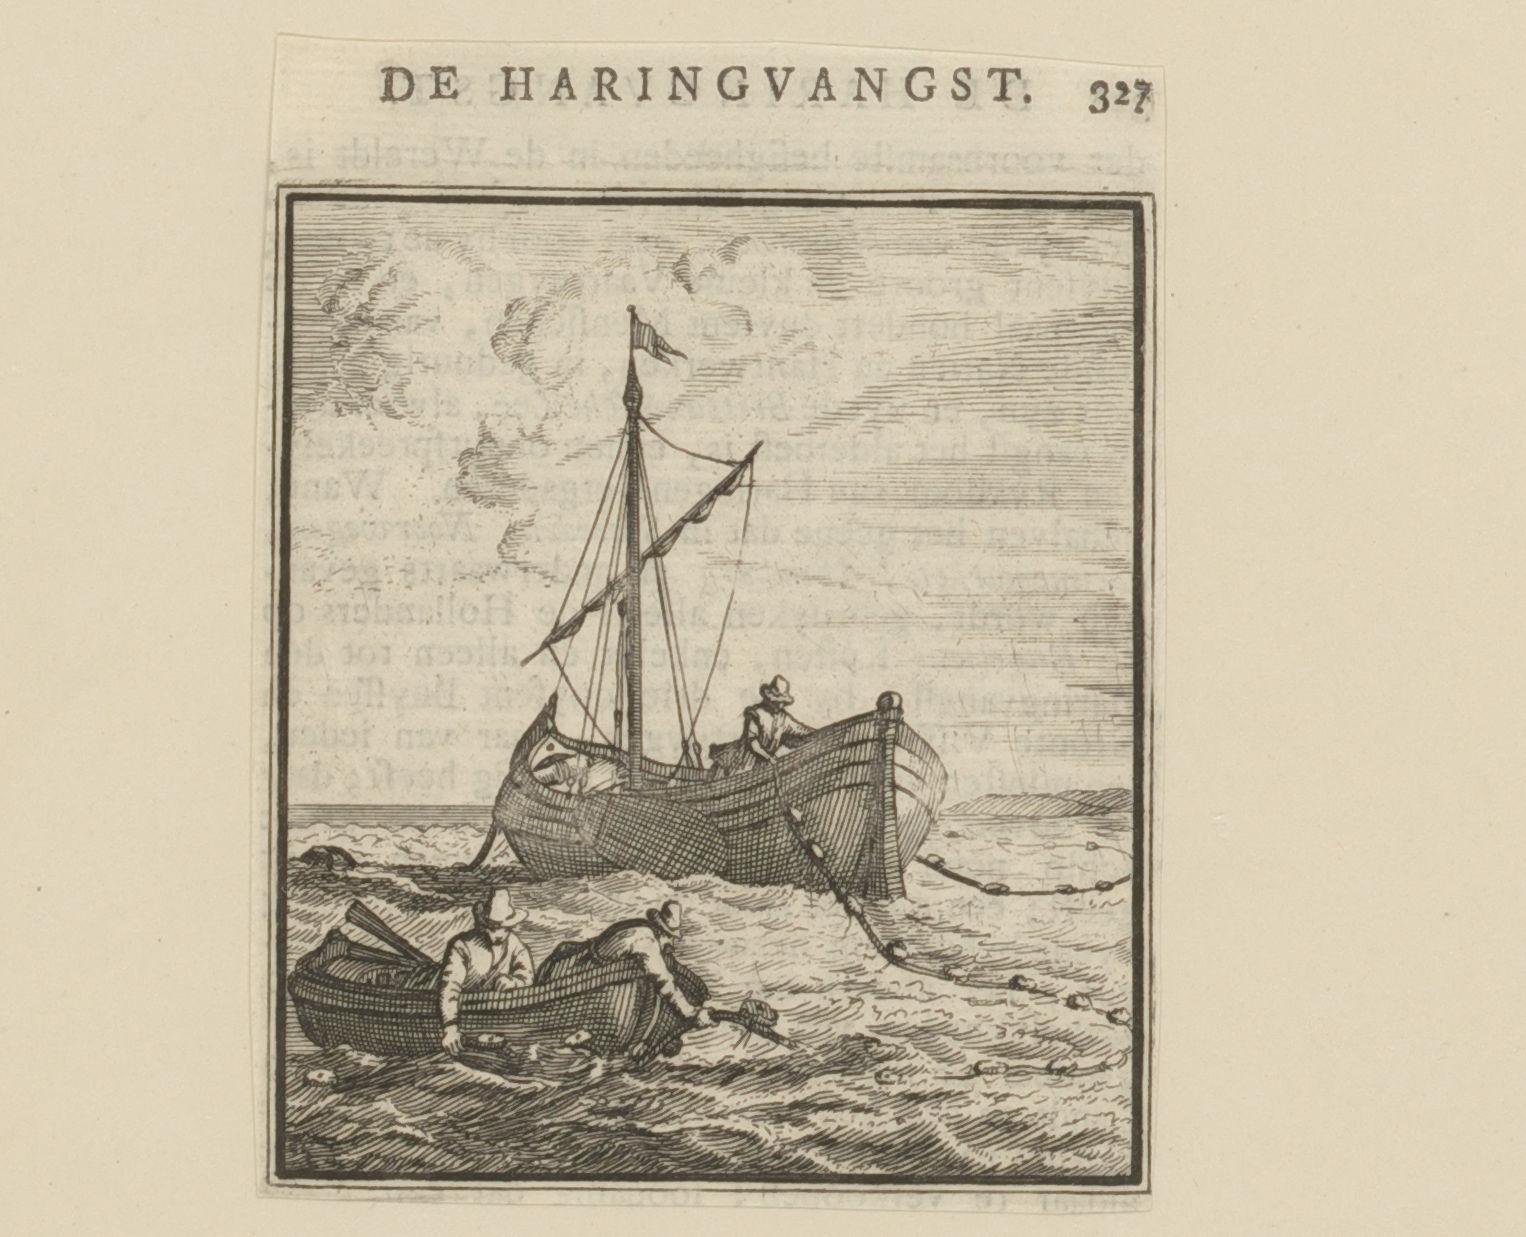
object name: print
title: De Haringvangst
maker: Anonymous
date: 1719-1759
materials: paper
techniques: etching, letterpress printing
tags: sailing-ship, sailing-boat, bony fishes: herring, herring fishery, rowing-boat, canoe, etc.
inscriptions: stamp, collector's mark: Lugt 1641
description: Prent met andere letterzetting gebruikt in: St. Clara, Abraham van. Iets voor allen. [Vertaald door] J. le Long. Amsterdam: Janssoons van Waesberge, 1719, dl. 2. En in: St. Clara, Abraham van. Iets voor allen. [Vertaald door] J. le Long. Amsterdam: Jan Roman de Jonge, 1741, dl. 2. En in: St. Clara, Abraham van. Iets voor allen. [Vertaald door] J. le Long. Amsterdam: Jan Roman, 1759, dl. 2. Huidige prent uit een andere editie. Naar een prent van: Jan Luyken.